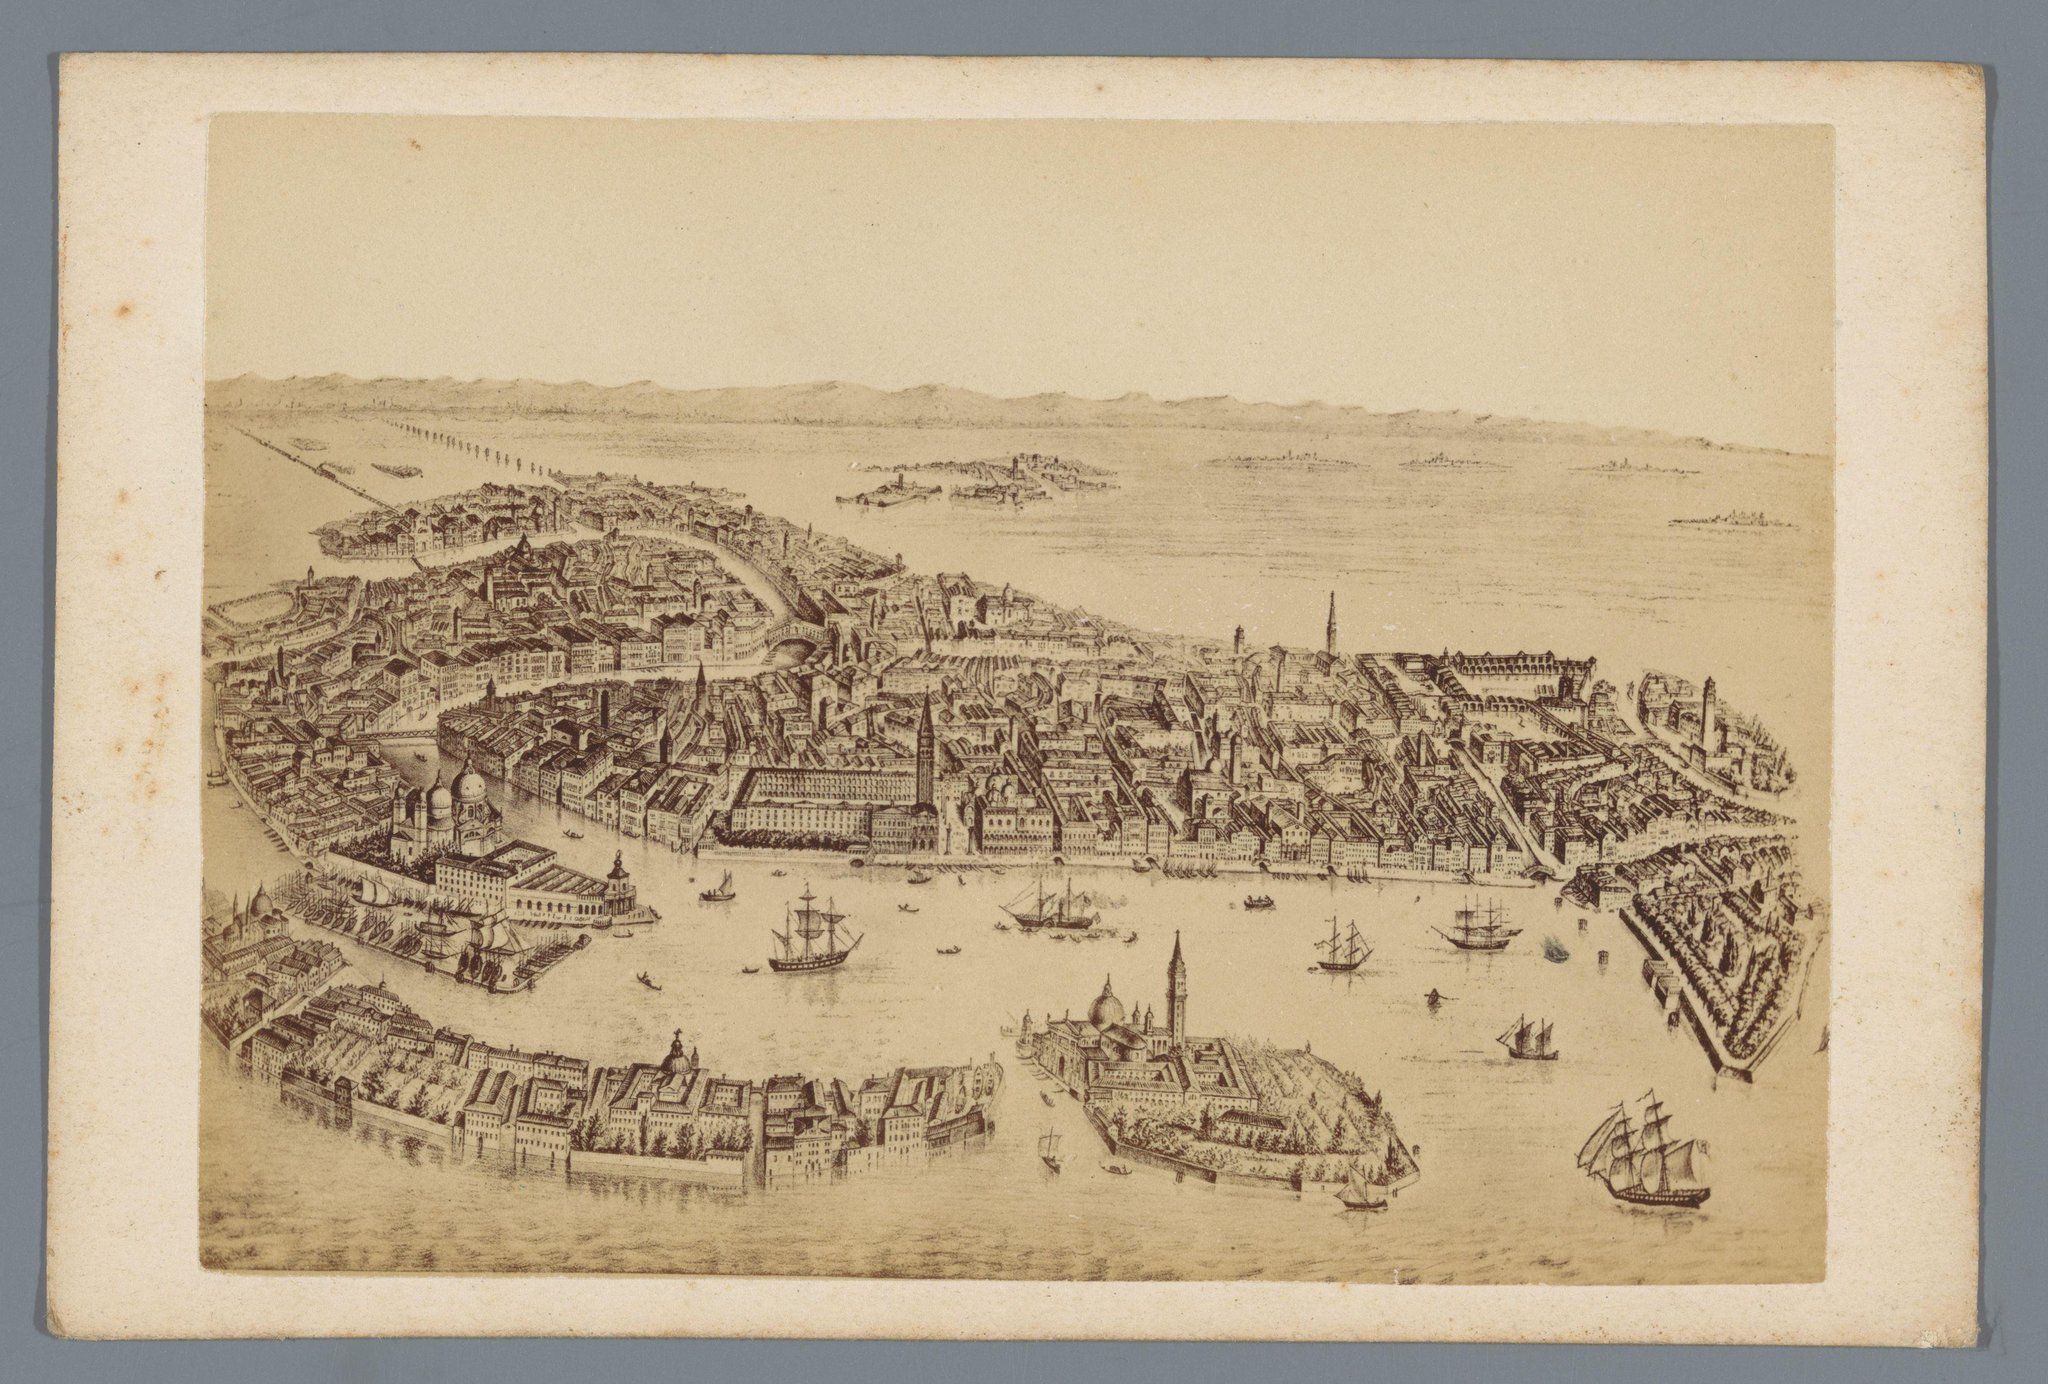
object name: cabinet photograph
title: Fotoreproductie van een getekend panorama op Venetië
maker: Anonymous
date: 1850-1900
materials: cardboard, photographic support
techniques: albumen print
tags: city-view, and landscape with man-made constructions, venice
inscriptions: annotation: ‘Venezia/ Panorama’